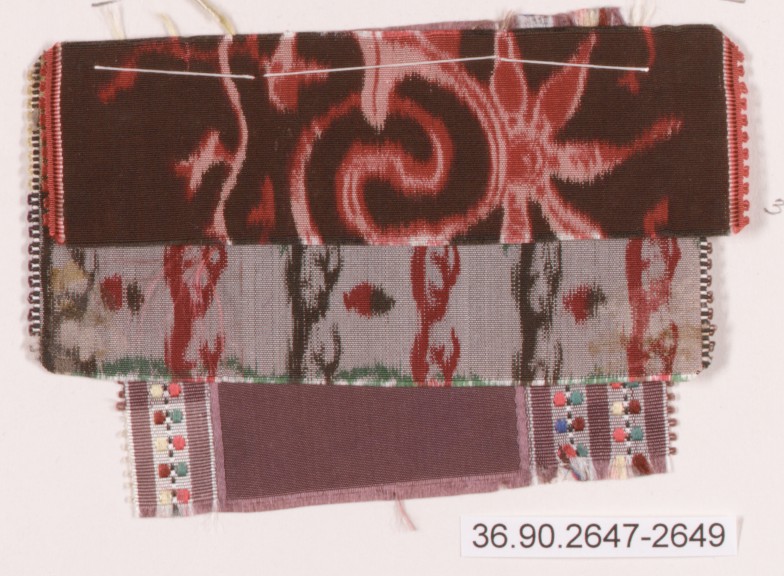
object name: ribbon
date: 1801-1900